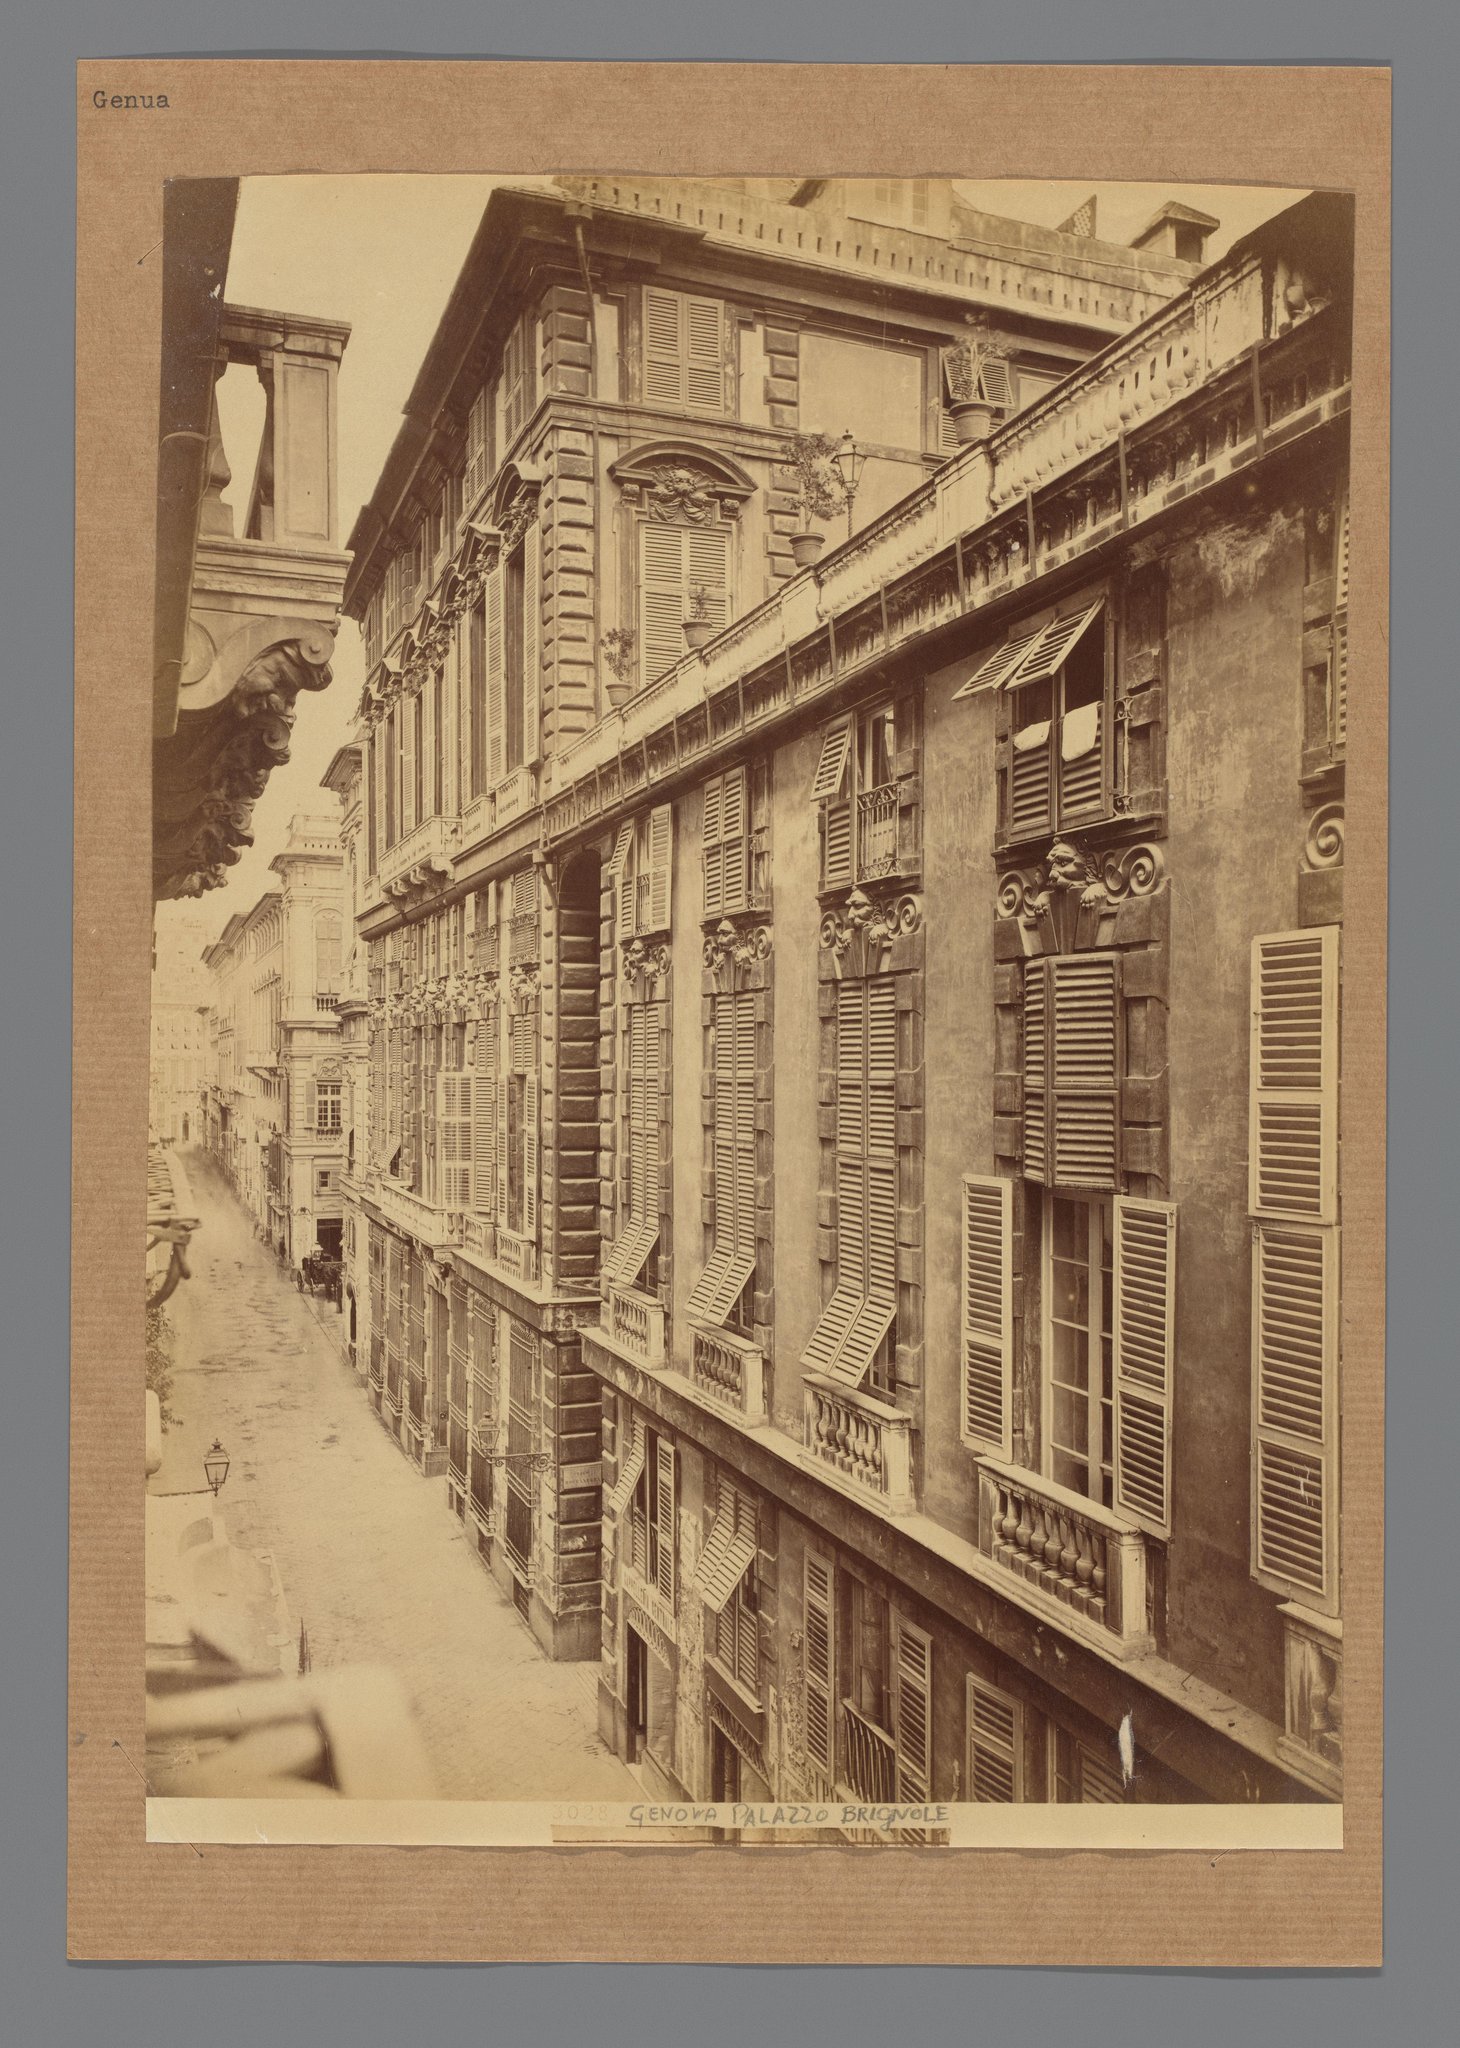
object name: photograph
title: Italië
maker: Anonymous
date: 1880-1910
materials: photographic support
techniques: albumen print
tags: italy